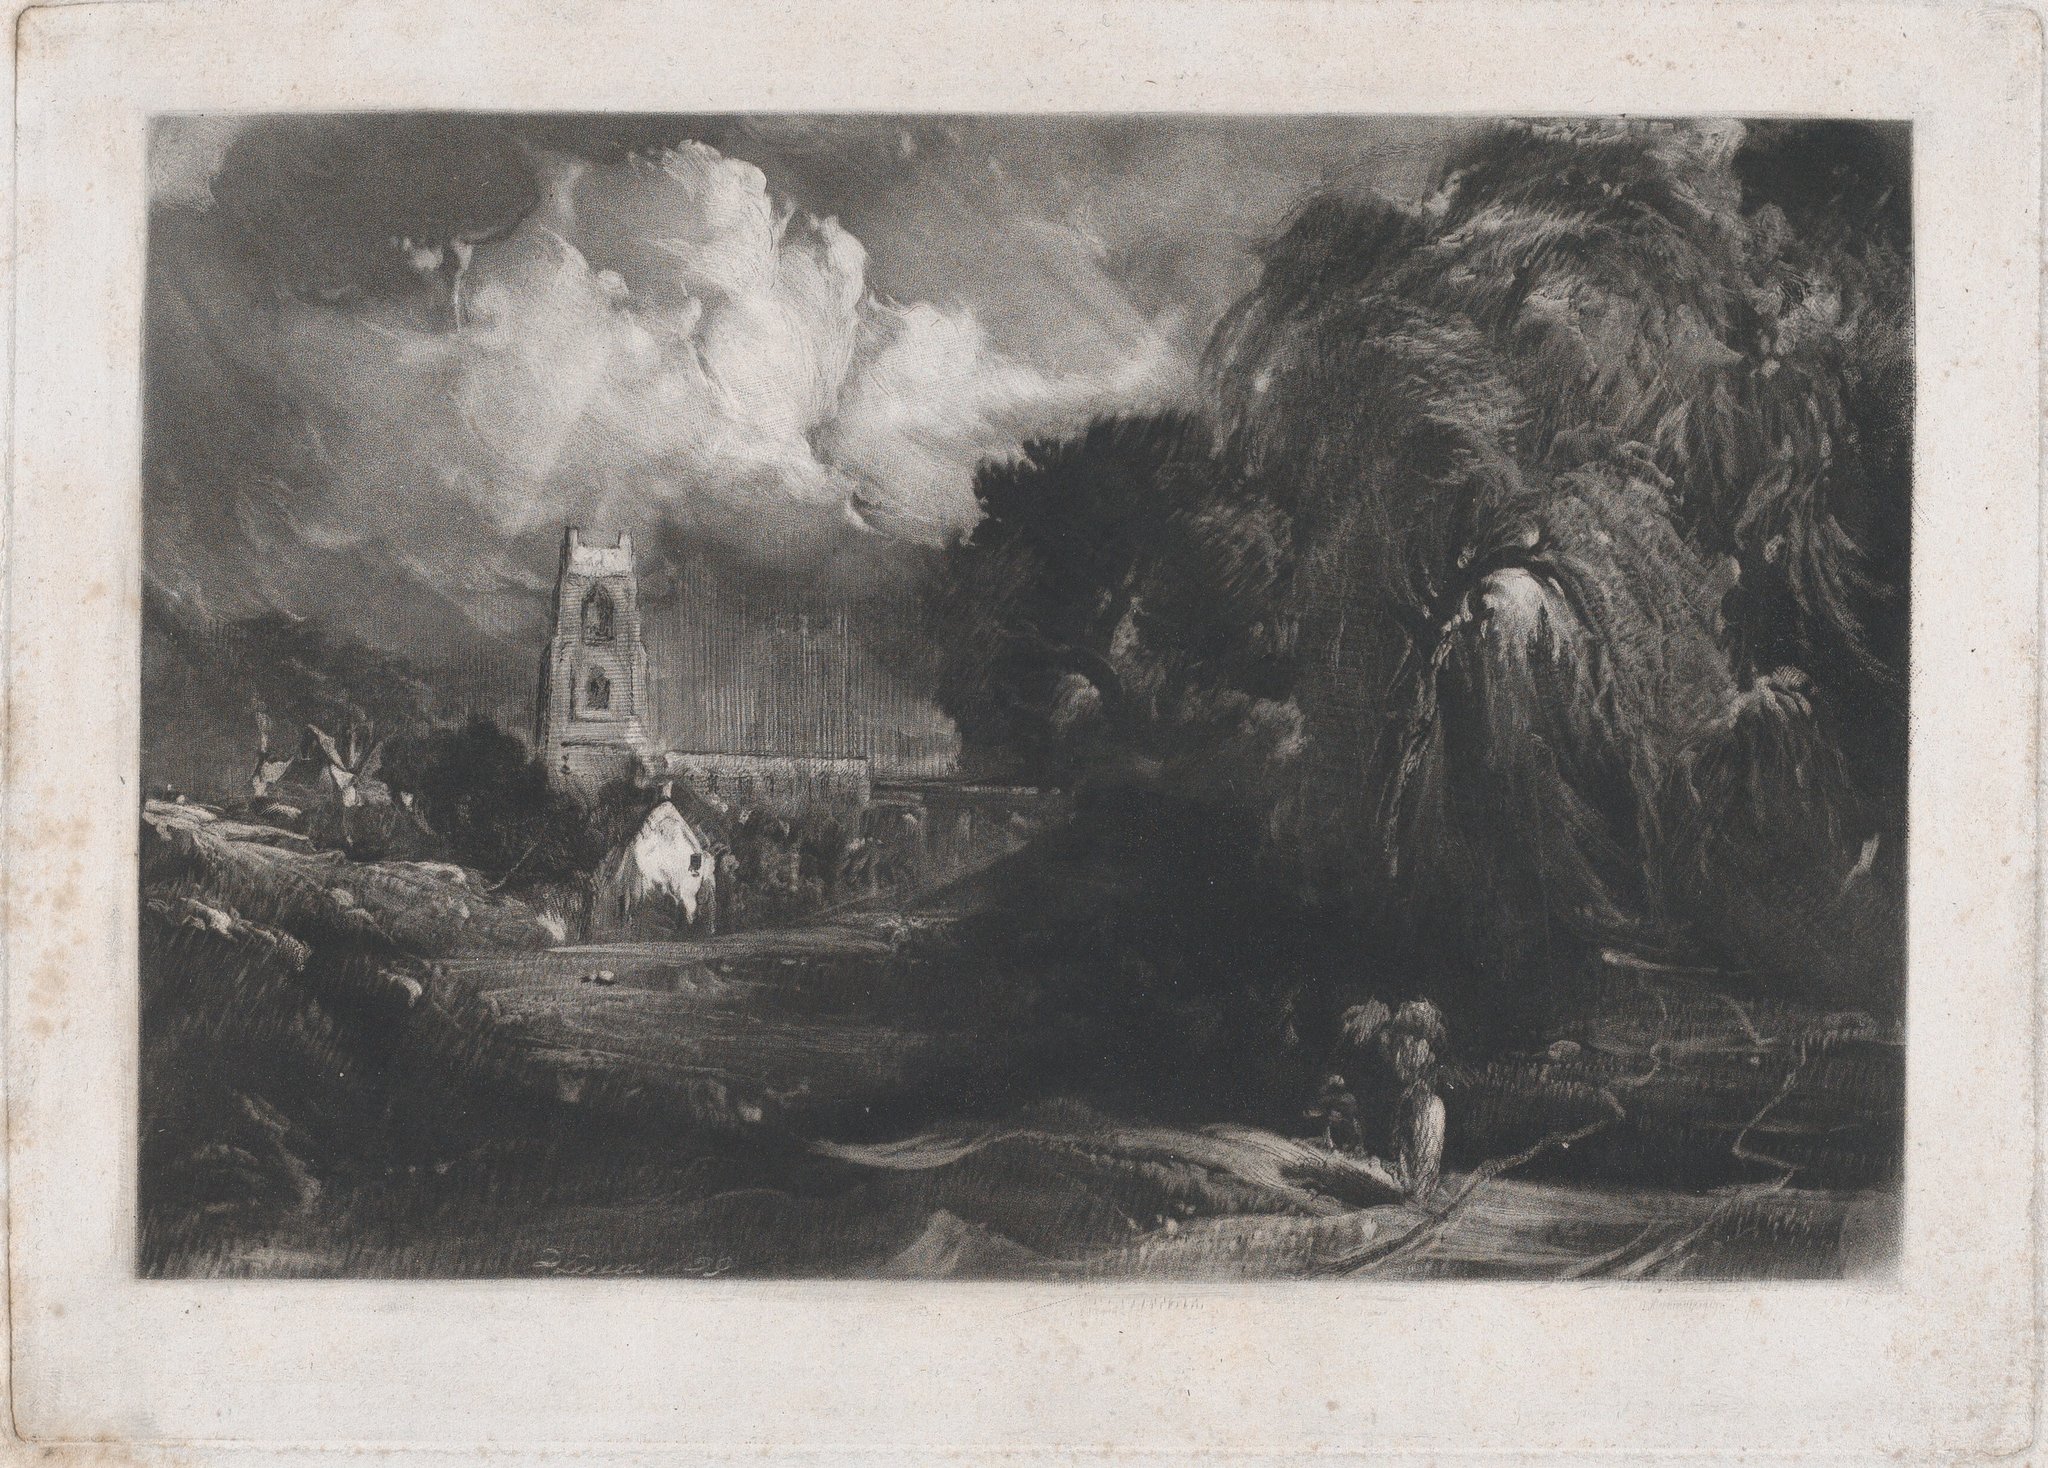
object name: print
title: Stoke-by-Neyland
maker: david lucas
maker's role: artist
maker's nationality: british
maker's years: 1802-1881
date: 1829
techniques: mezzotint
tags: villages,landscapes,trees